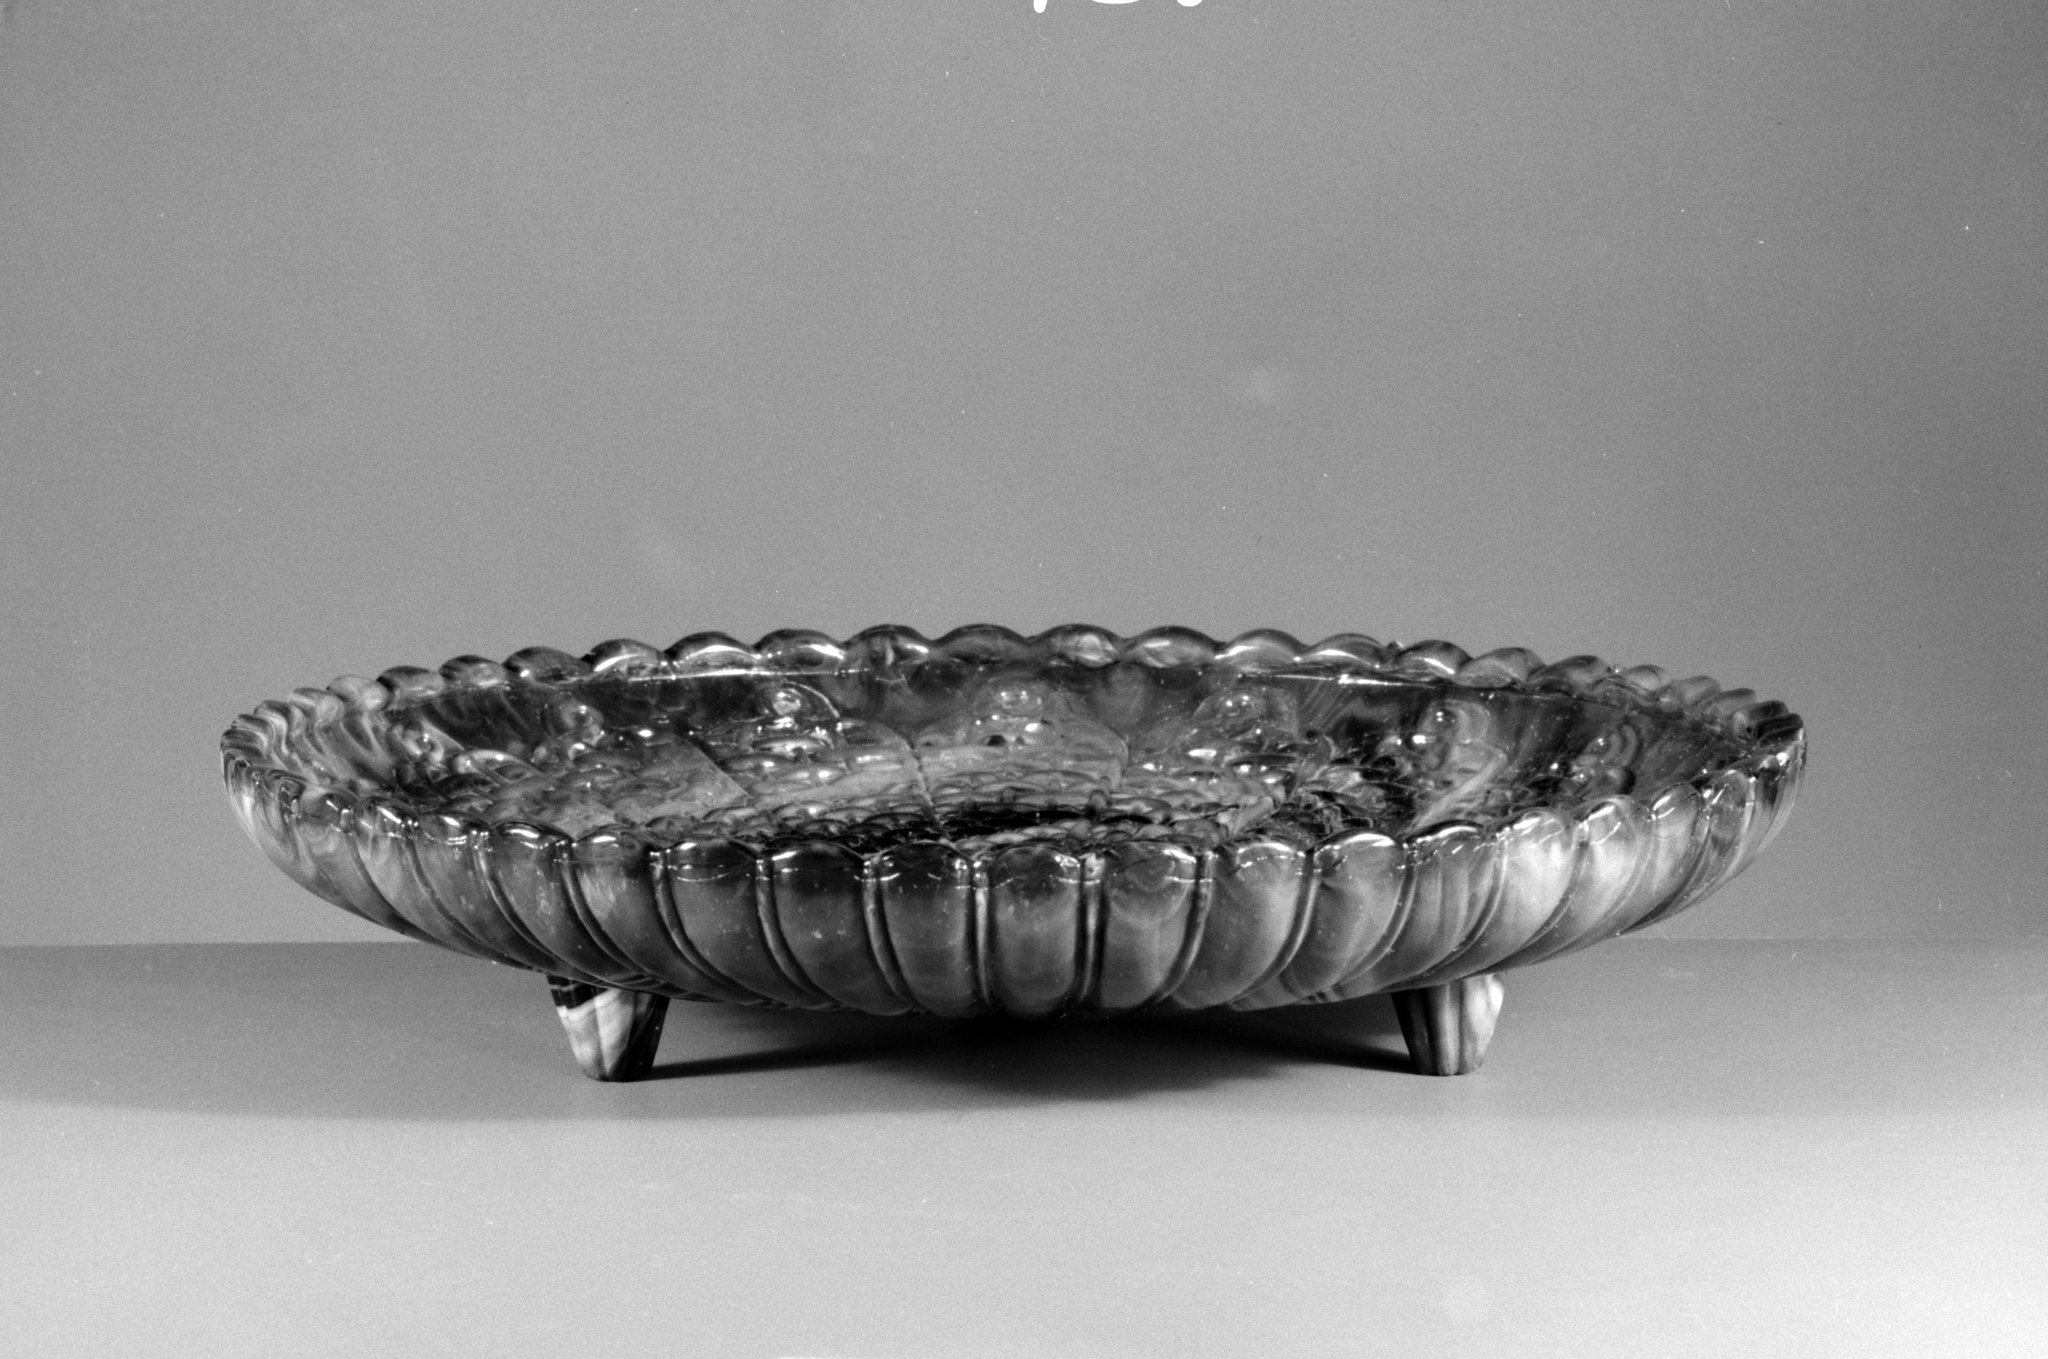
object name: plate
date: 1880-1890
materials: glass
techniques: pressed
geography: england